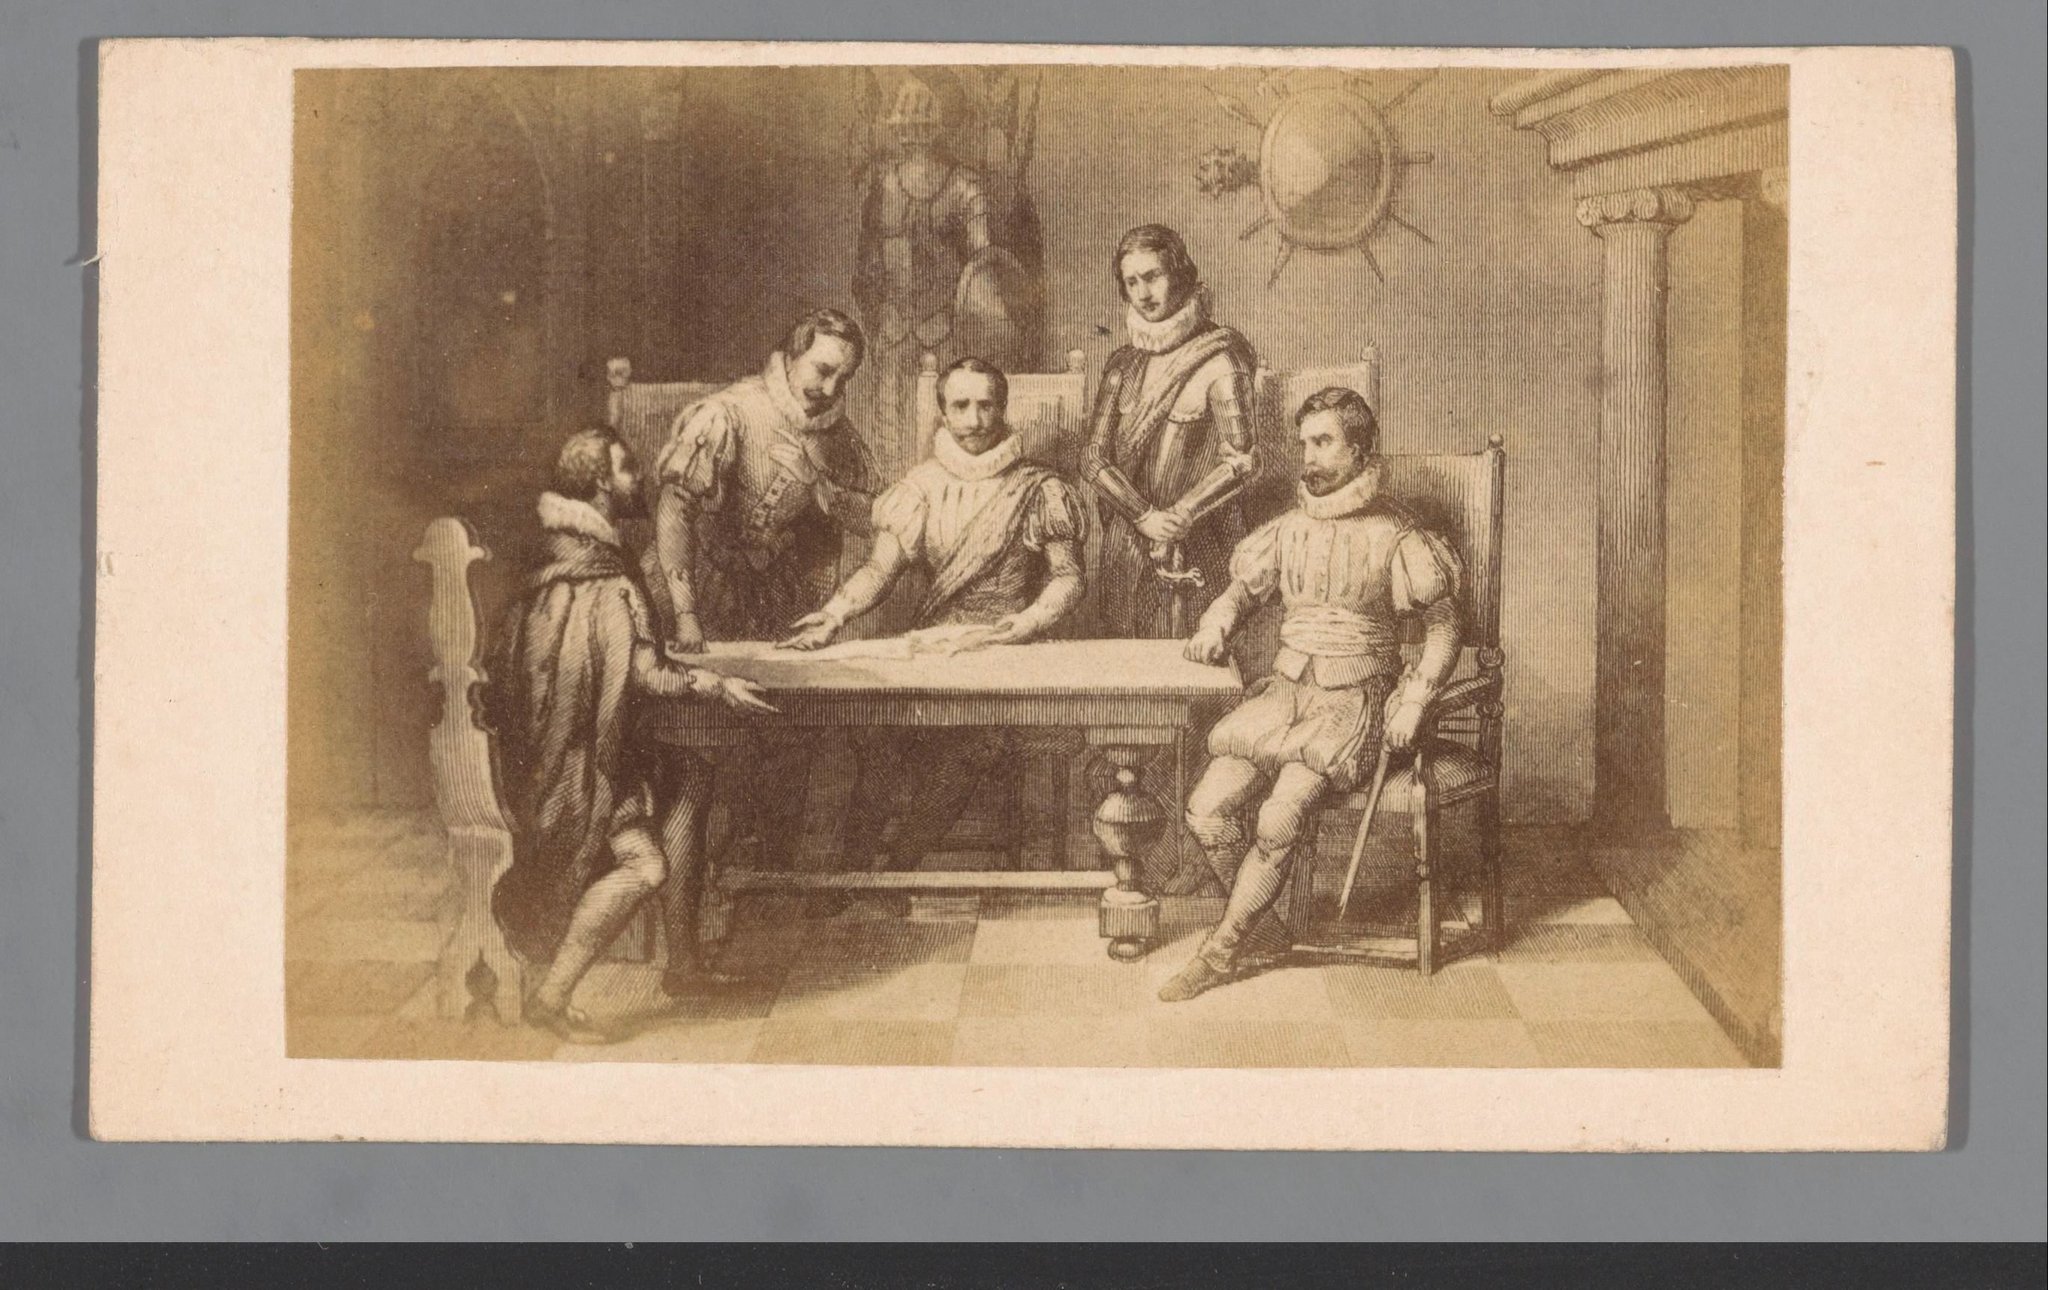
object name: carte de visite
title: Fotoreproductie van een gravure van de bijeenkomst van Oranje, Horne, Egmond, Hoogstraten en Lodewijk van Nassau in Dendermonde op 3 oktober 1566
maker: Anonymous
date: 1850-1900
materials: cardboard, photographic support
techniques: albumen print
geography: netherlands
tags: delft, william i (prince of orange), brussels, earl, meeting, assembly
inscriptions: inscription: ‘Bijeenkomst te (...) is geworden.’, number: ‘5’